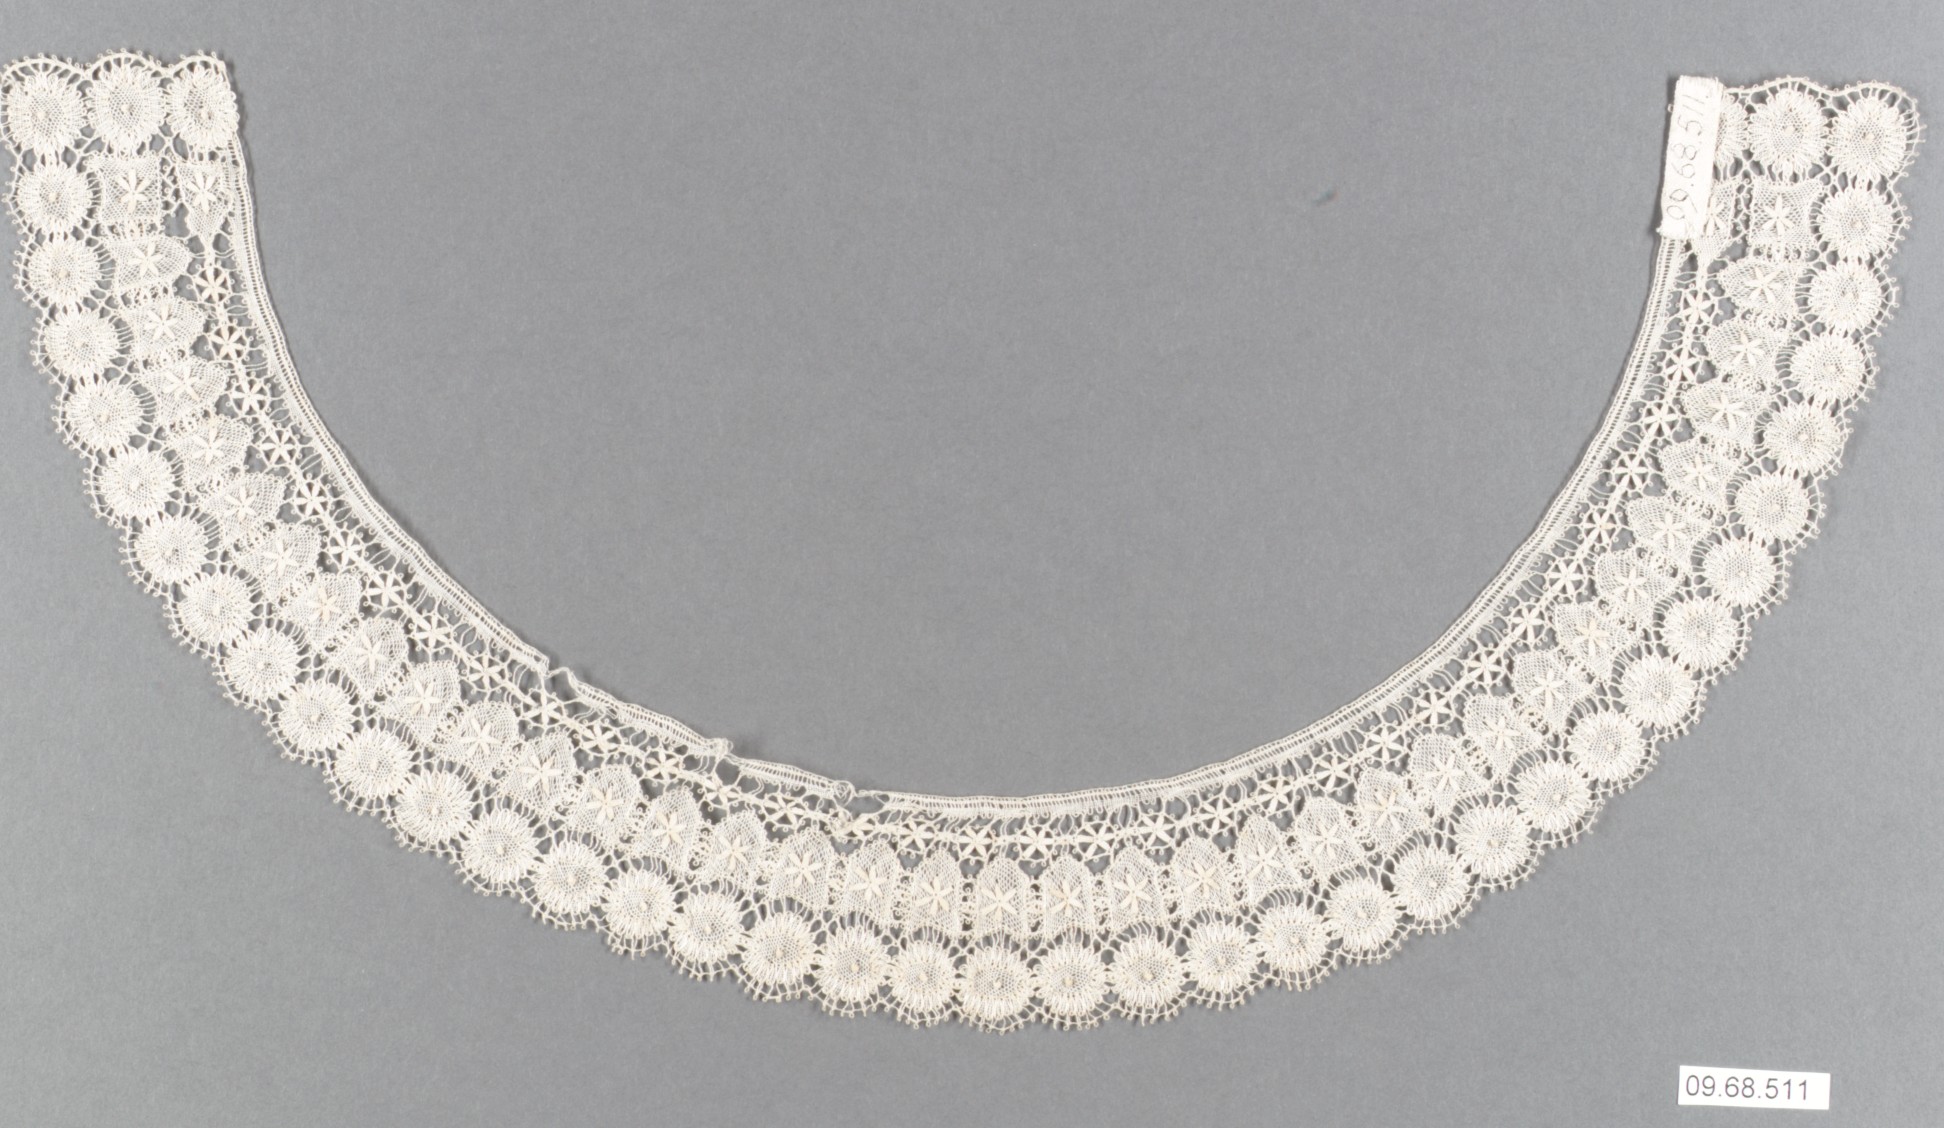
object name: collar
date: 1801-1900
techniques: lace